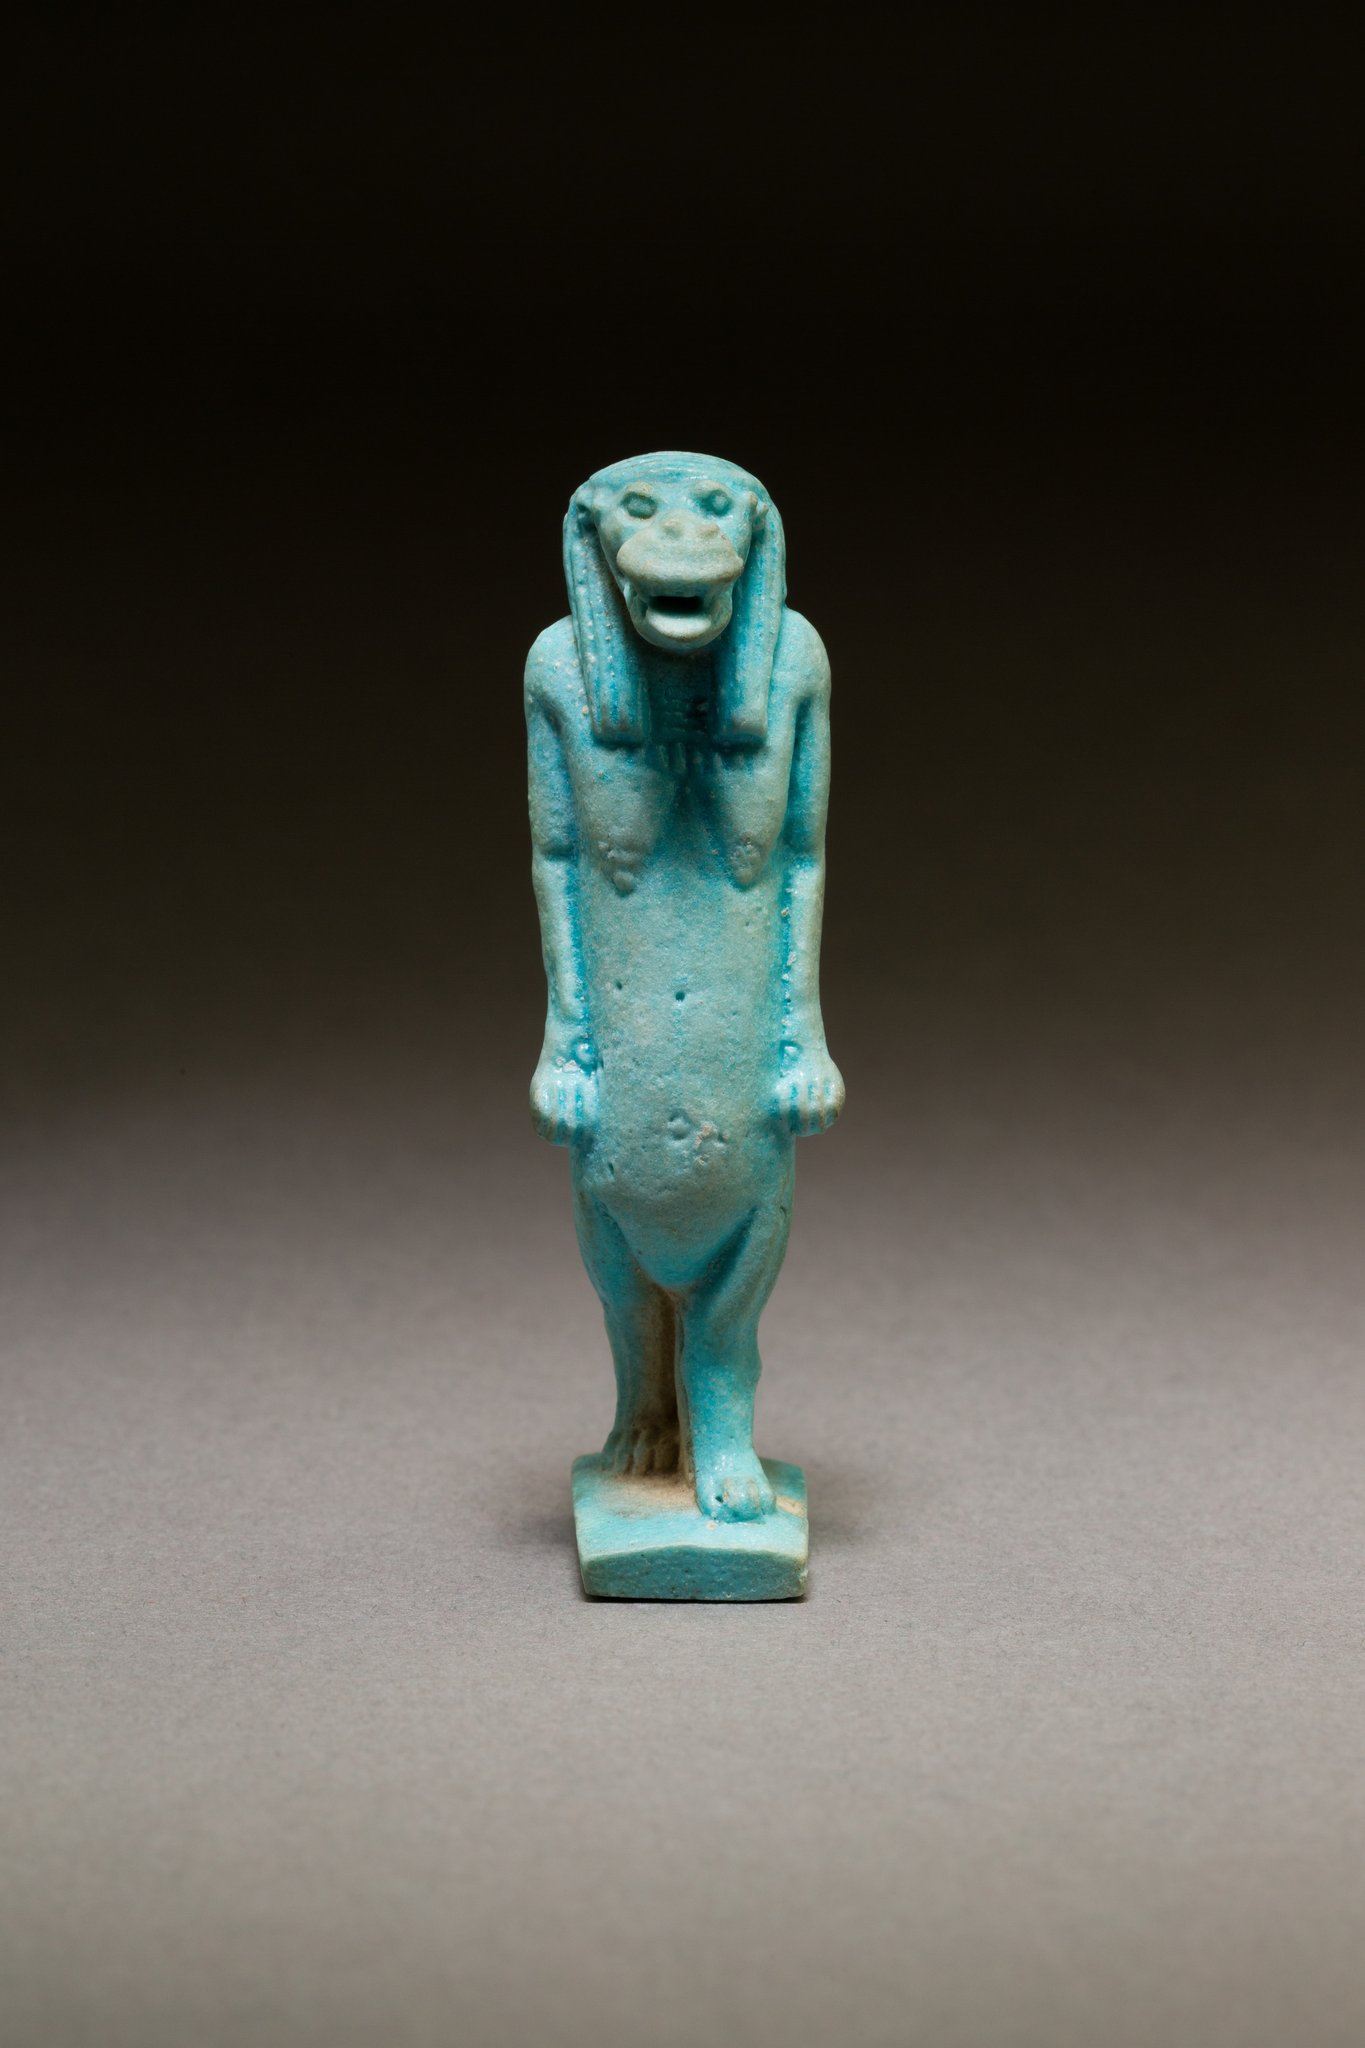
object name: amulet, taweret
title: Taweret amulet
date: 664-630 BCE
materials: faience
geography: egypt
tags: taweret